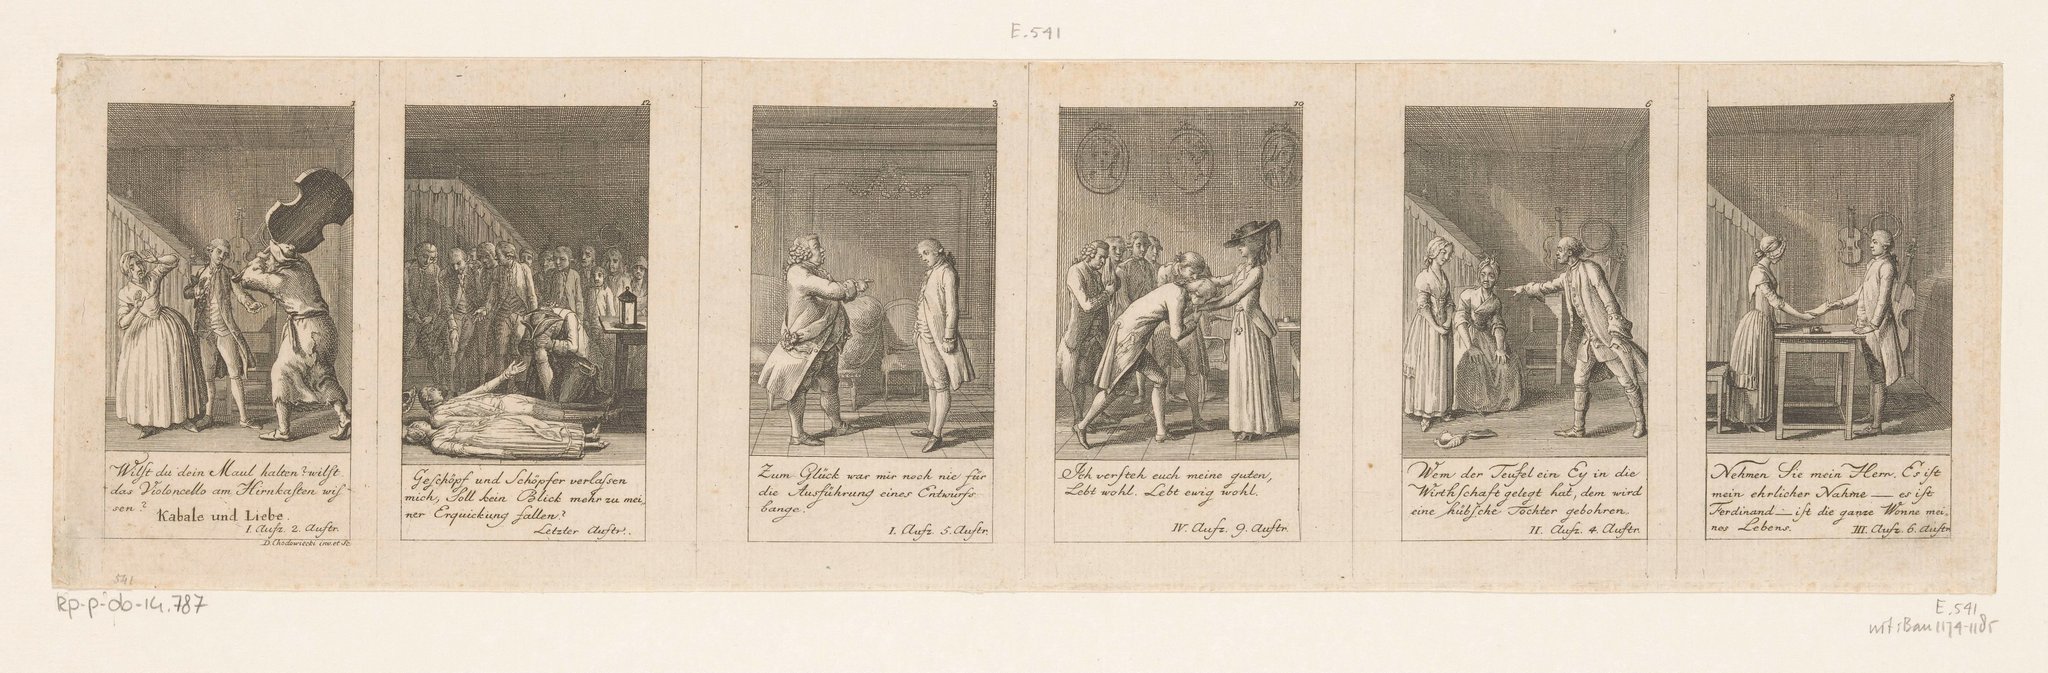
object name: print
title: Zes voorstellingen uit Schillers Kabale und Liebe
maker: daniel nikolaus chodowiecki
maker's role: draughtsman, print maker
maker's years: 1726-1801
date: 1785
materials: paper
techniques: etching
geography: berlin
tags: literature, president ~ head of republic, viola, violoncello; double bass, weeping, quarrel, argument, kissing the hand (lovers)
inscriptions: collector's mark: Lugt 2228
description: Vervaardigd voor Friedrich von Schiller 'Kabale und Liebe'. Prenten gebruikt voor: Königl. Grossbrit. Genealogischer Kalender auf das Jahr 1786. Lauenburg: J. G. Berenberg, 1785.